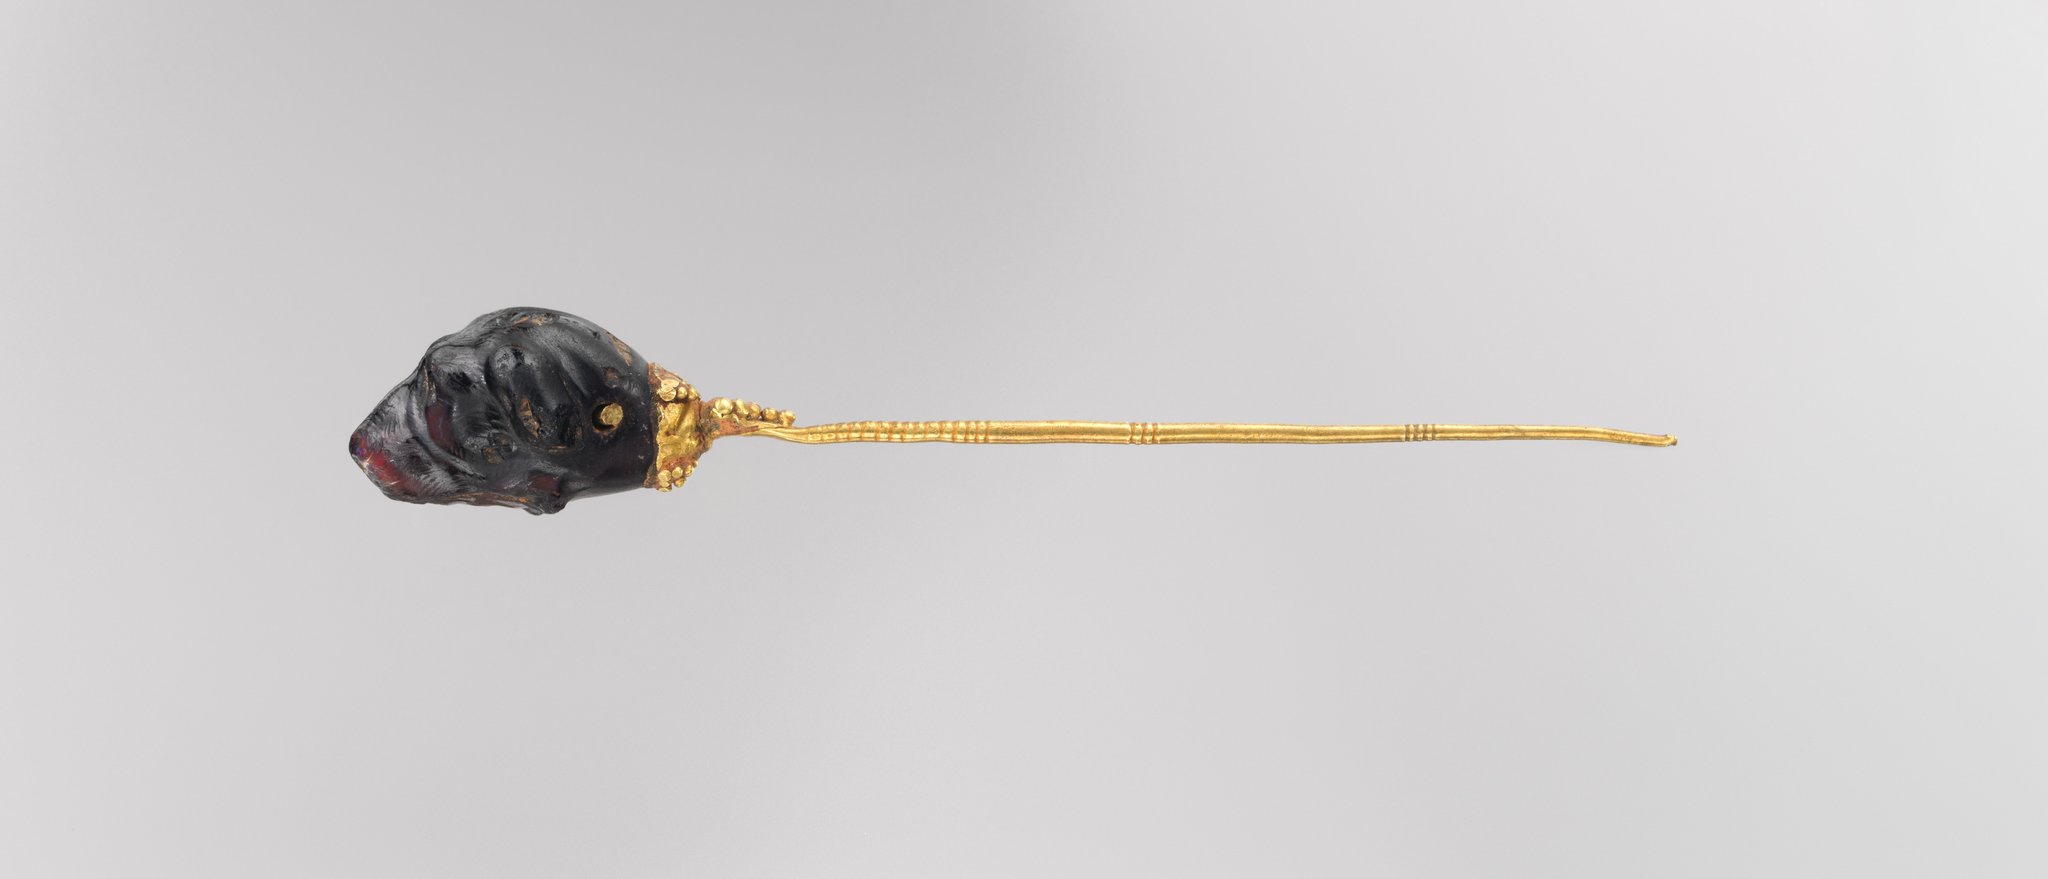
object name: pin with obsidian finial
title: Gold pin with obsidian finial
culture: roman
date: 1-100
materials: gold, obsidian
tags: animals